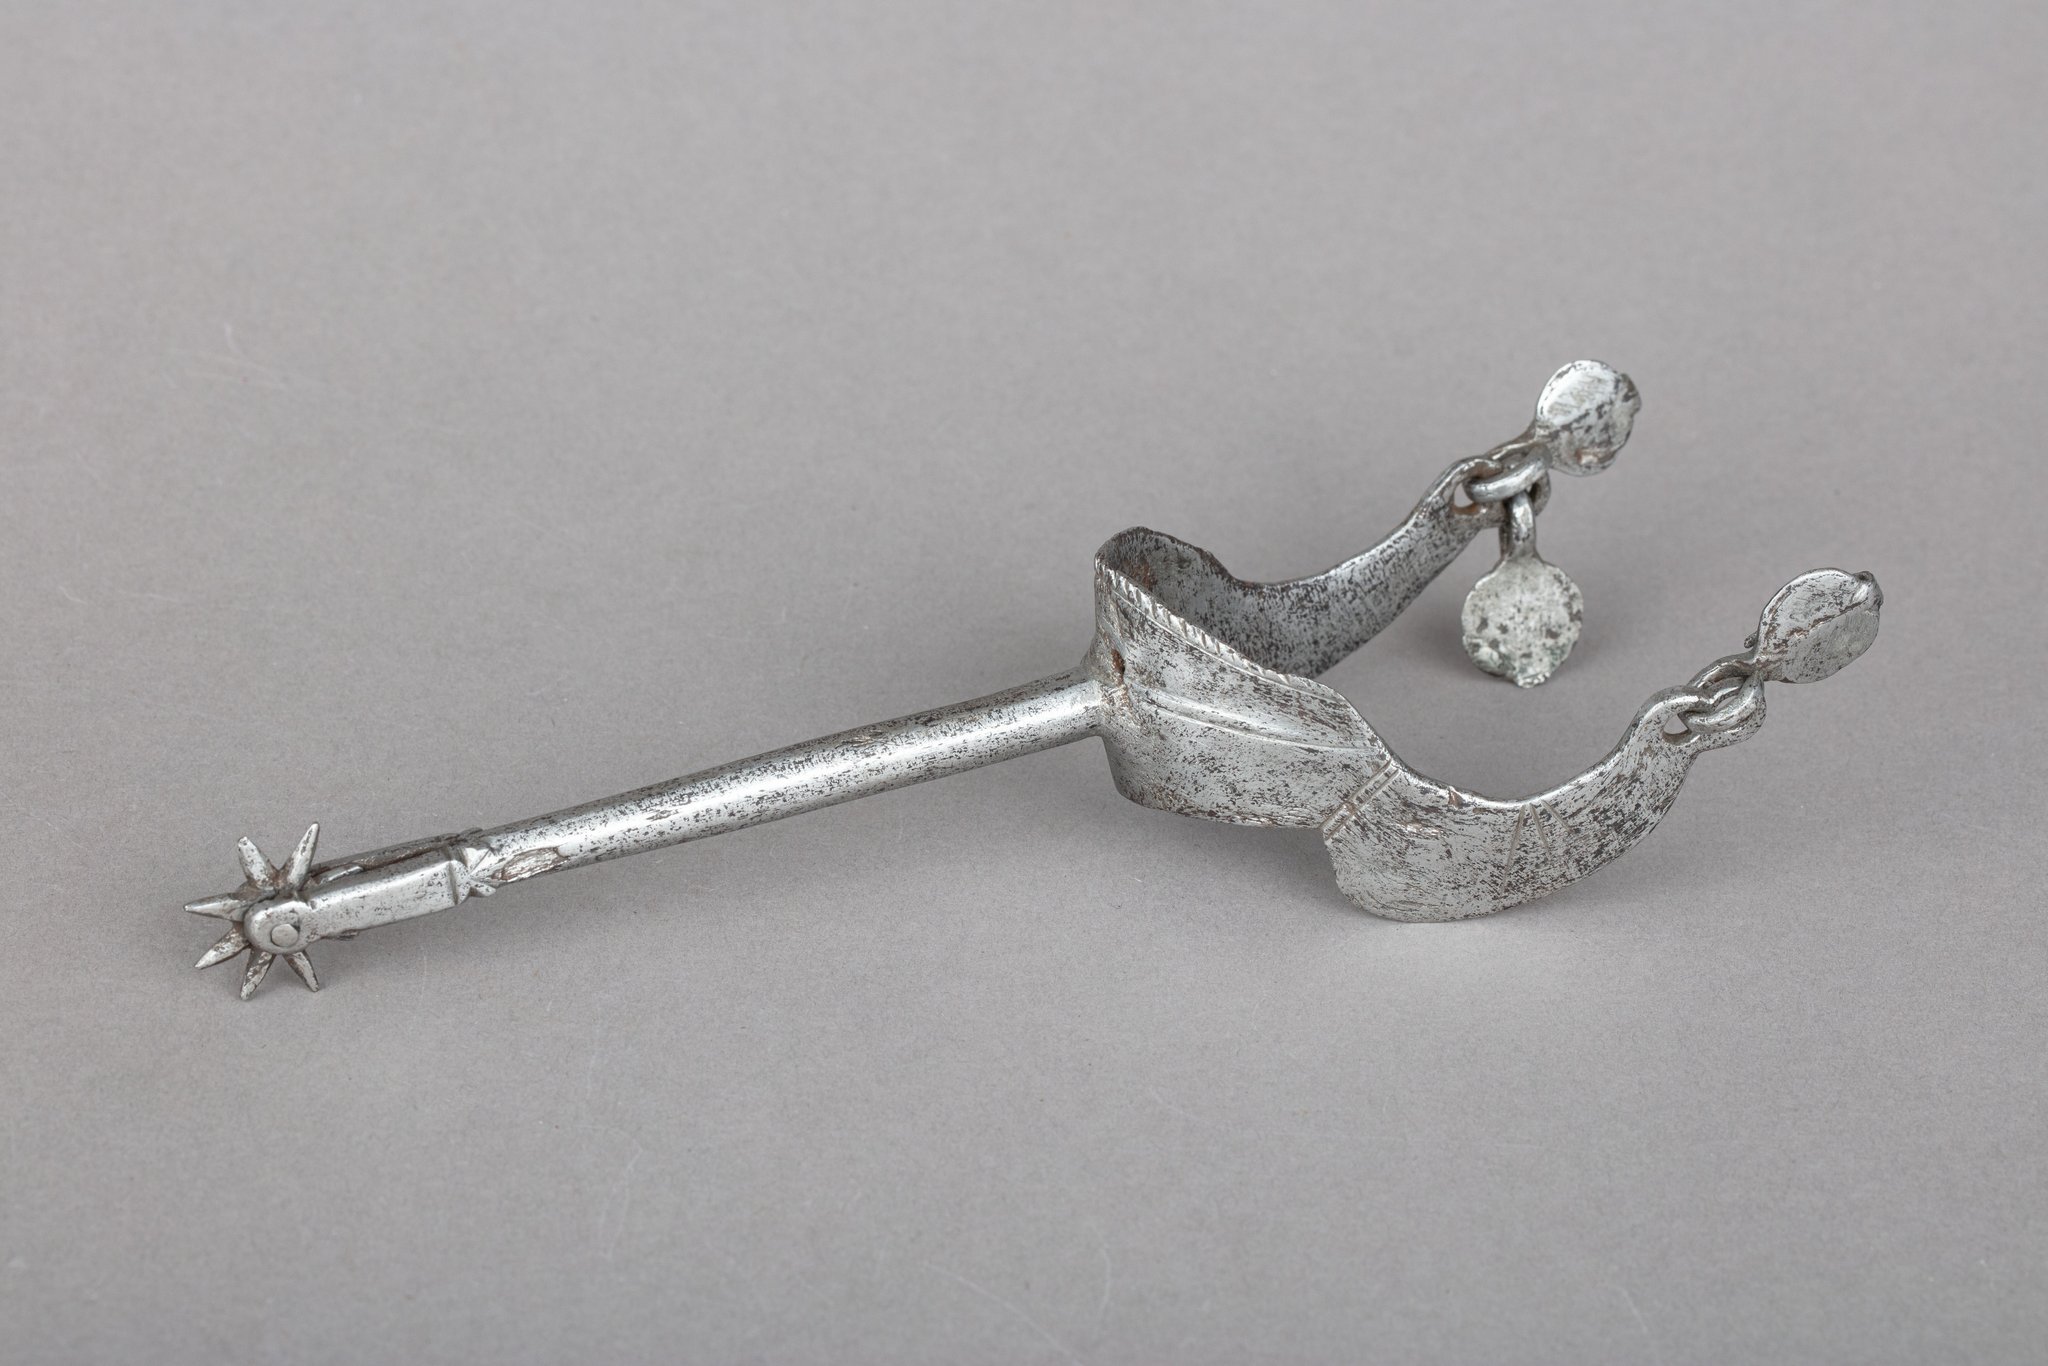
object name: rowel spur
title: Rowel Spur (Left)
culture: german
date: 1401-1500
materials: metal alloy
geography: germany